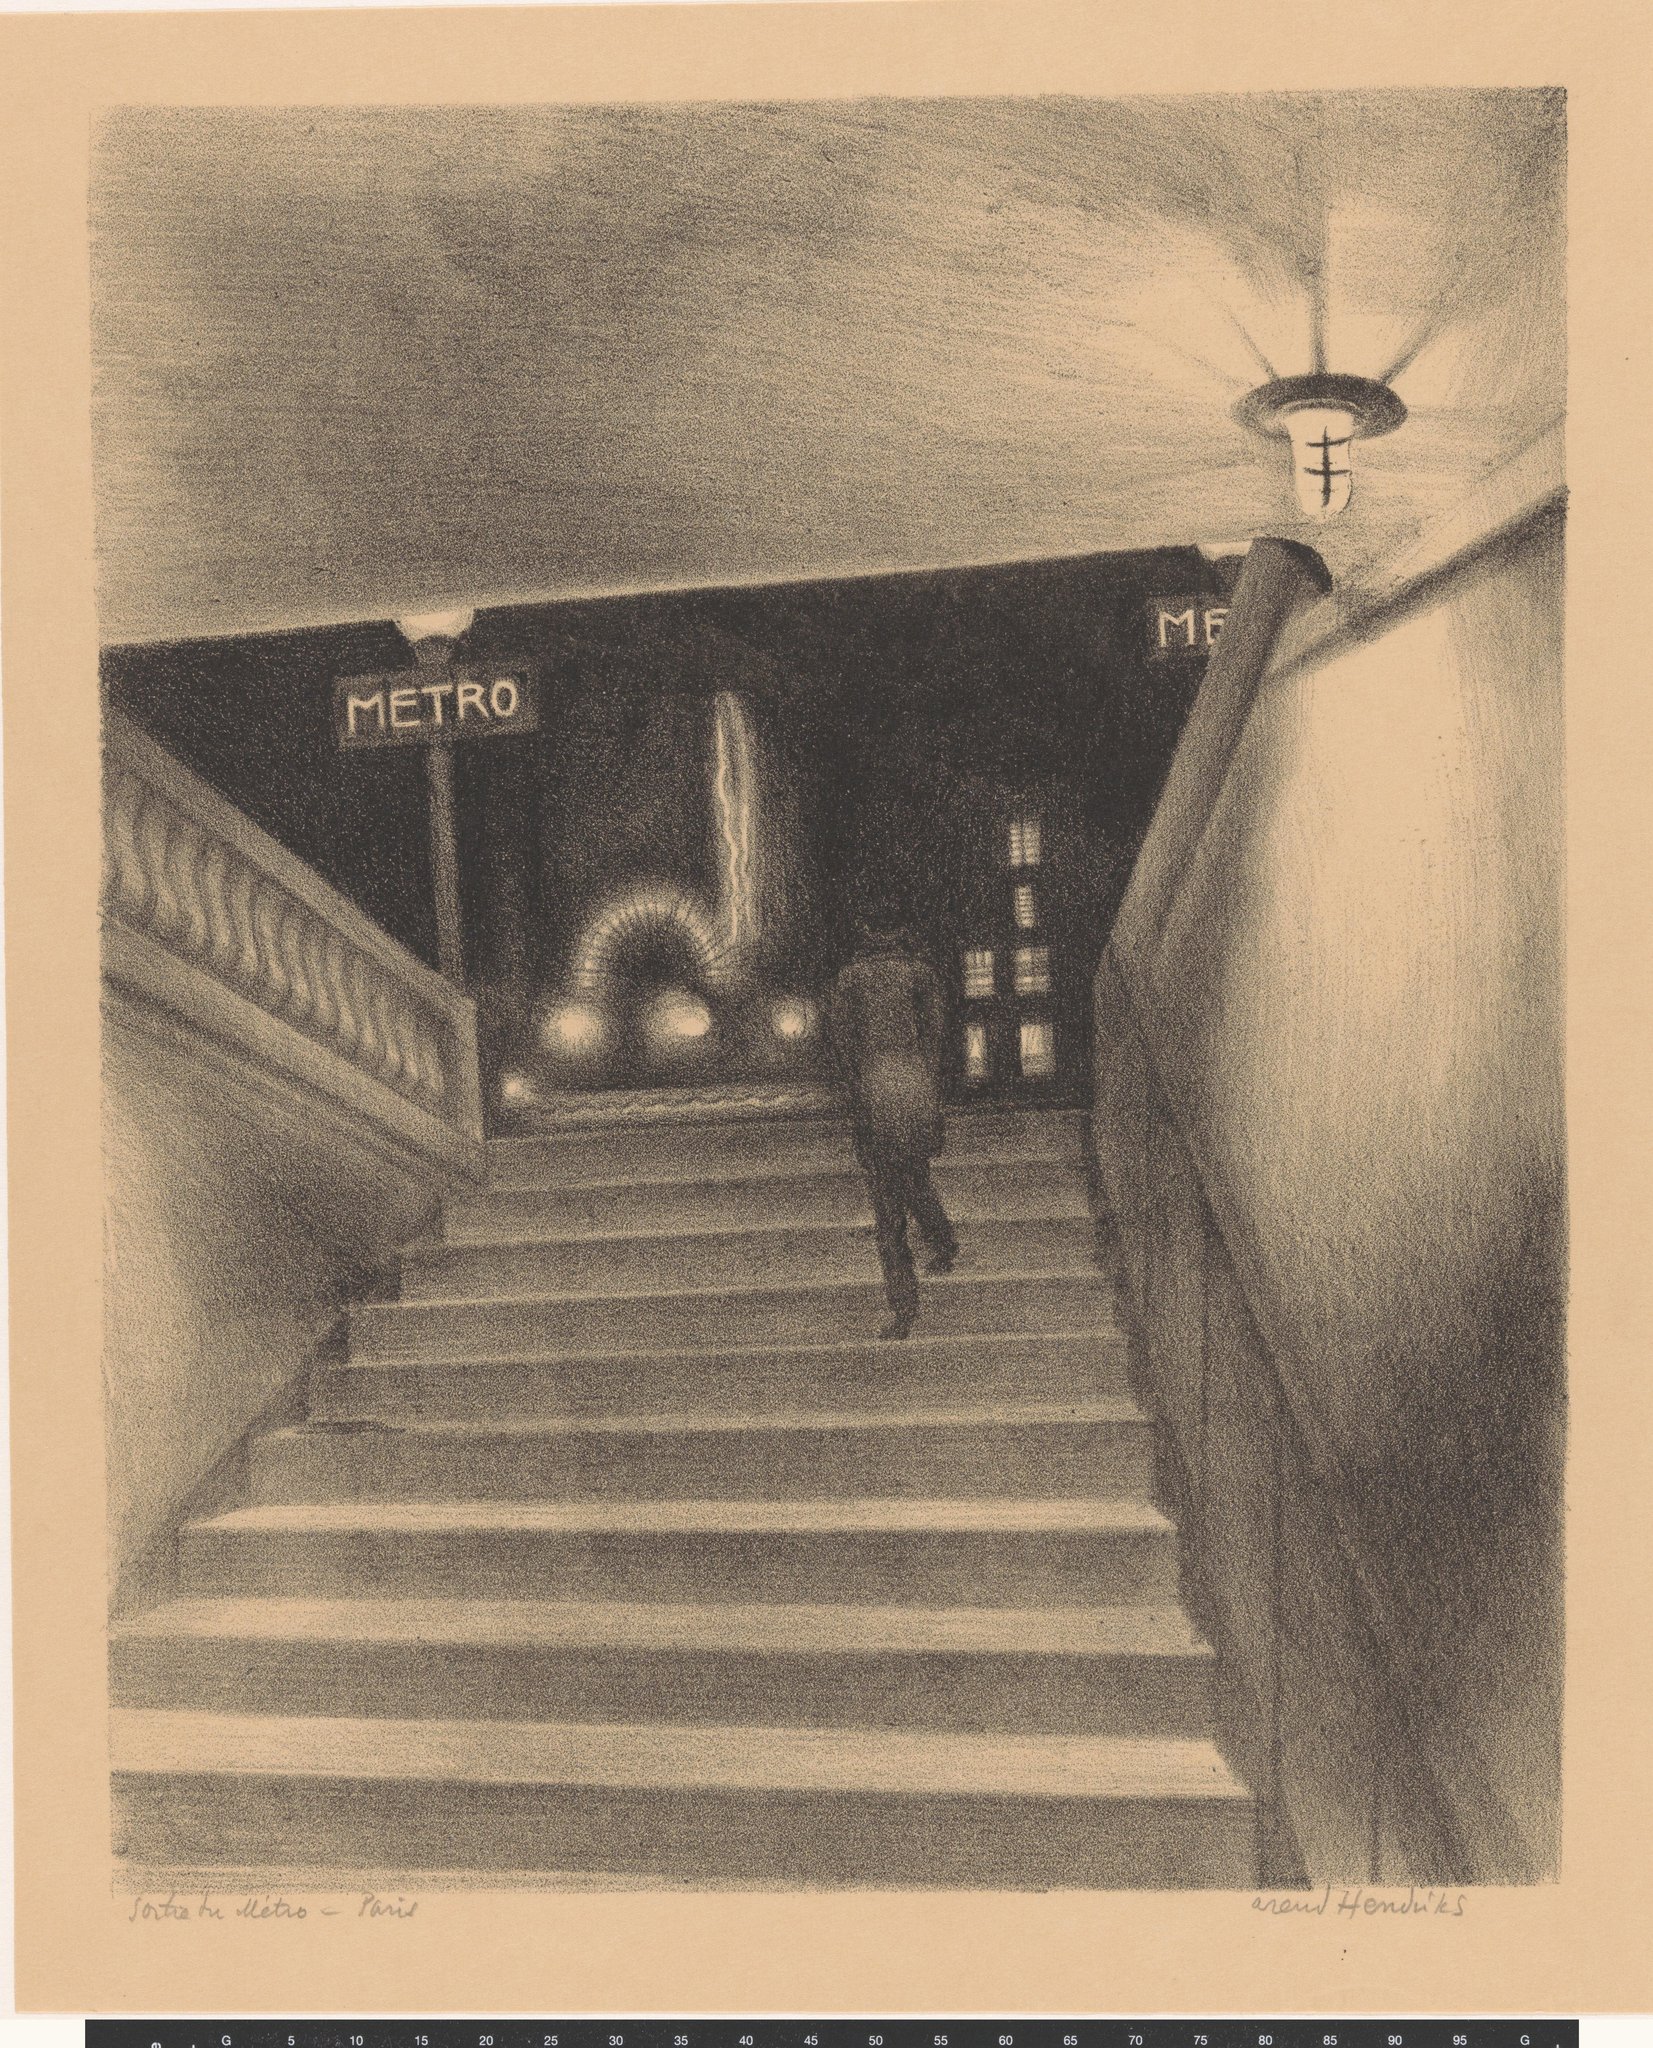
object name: print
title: Sortie du Métro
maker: arend hendriks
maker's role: print maker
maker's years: 1901-1951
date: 1911-1931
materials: paper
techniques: lithograph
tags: underground railway, 'métro', sloping street; street with steps or stairs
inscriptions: collector's mark: Lugt 2228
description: Een man verlaat een ondergronds metrostation via een trap. Op de achtergrond twee verlichte borden met de tekst 'Metro'.